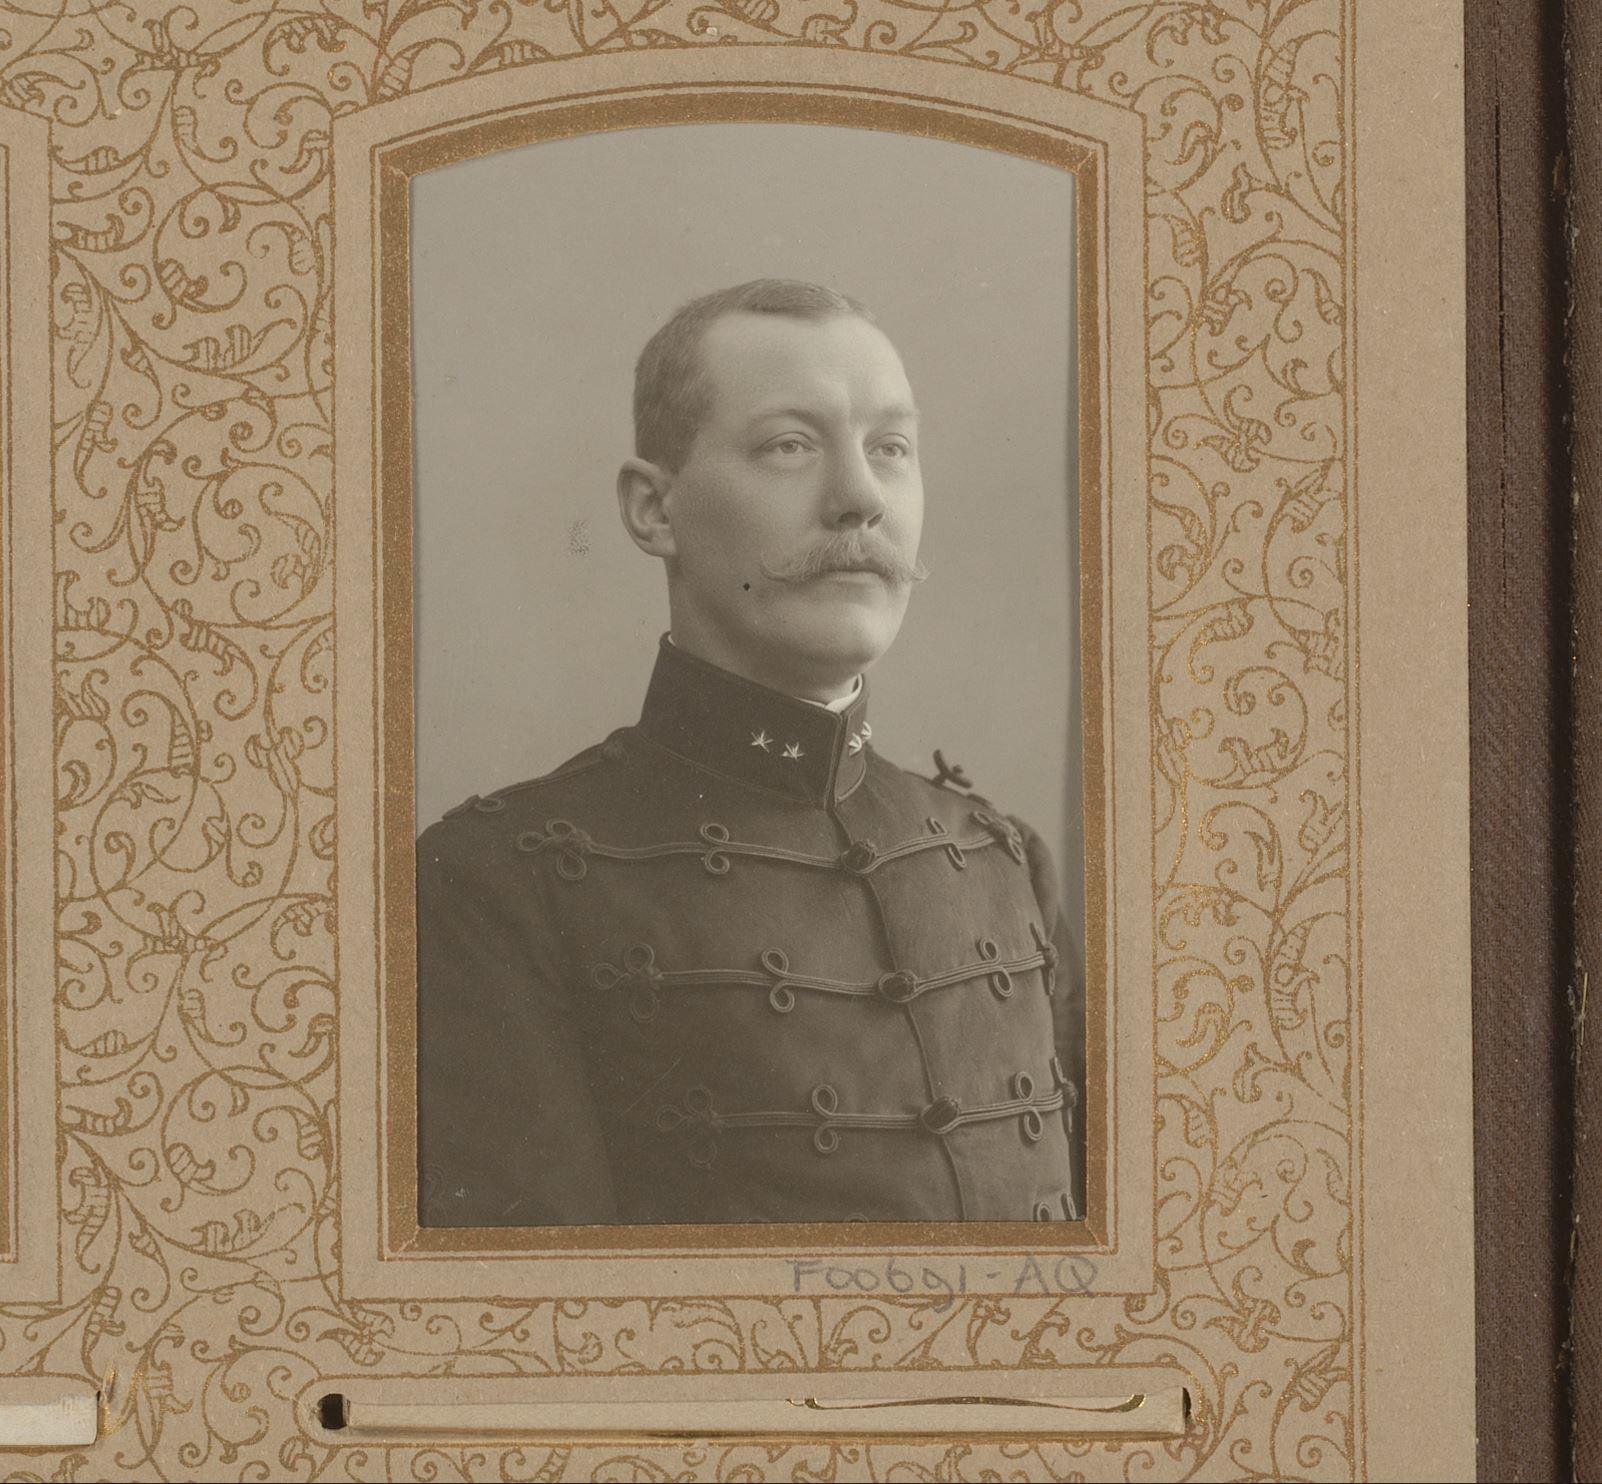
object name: carte de visite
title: Portret van een man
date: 1890-1920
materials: cardboard, photographic support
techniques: gelatin silver print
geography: the hague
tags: historical persons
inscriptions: inscription: ‘Jac. Schotel Sz/ Den Haag’